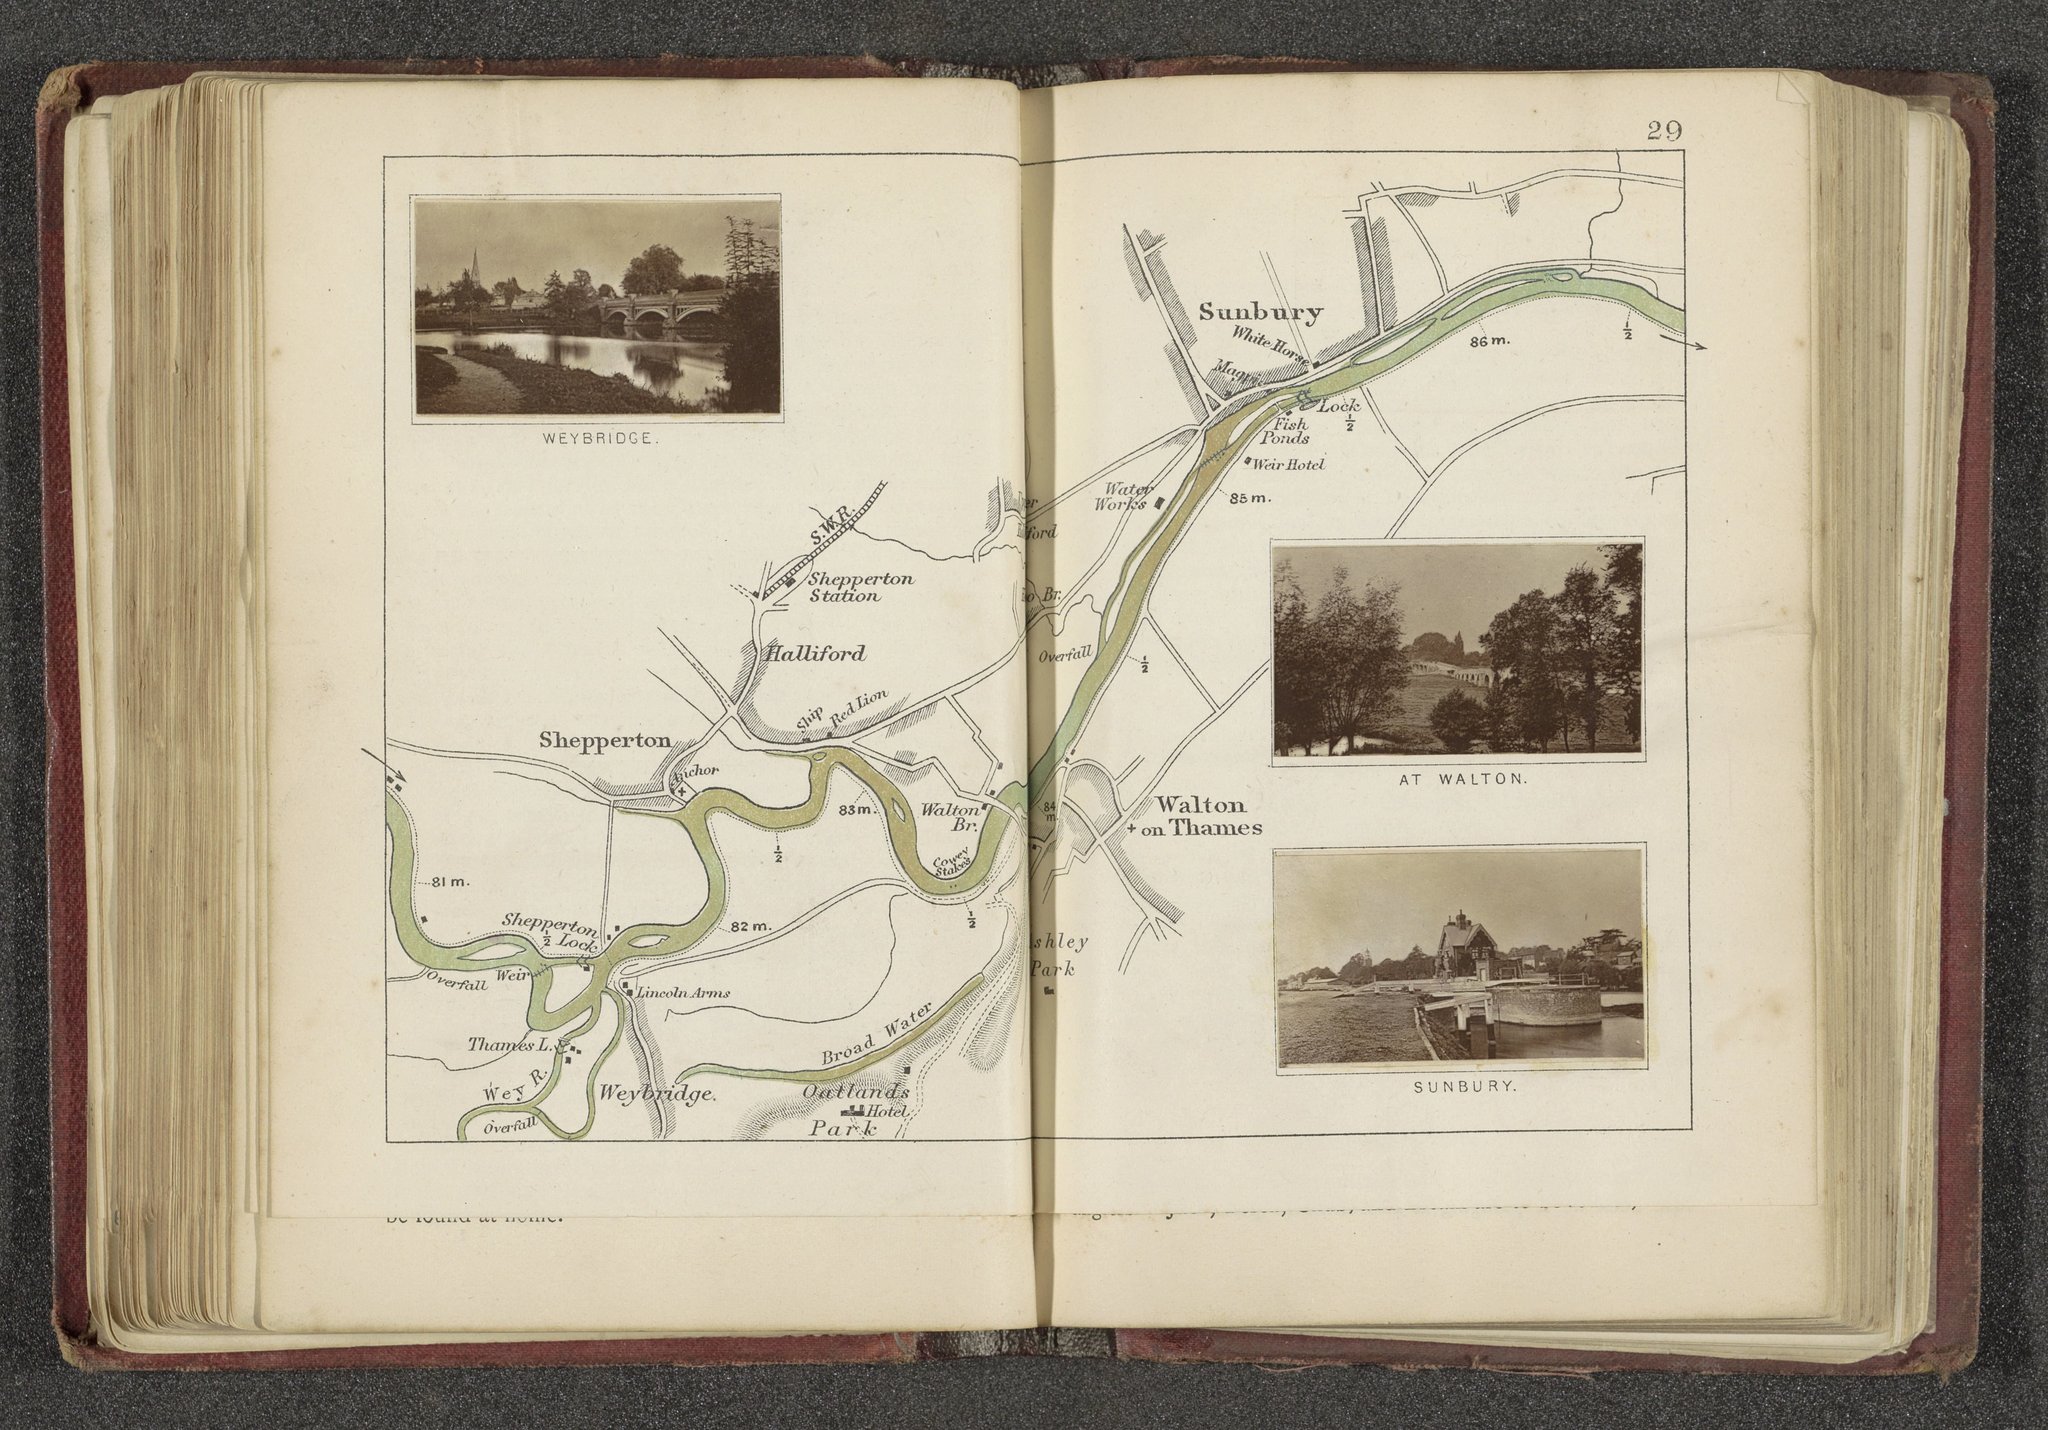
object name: page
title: Kaart met drie afbeeldingen van plaatsen langs de Theems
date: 1878-1879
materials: paper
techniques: engraving, woodburytype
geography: surrey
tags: river, bridge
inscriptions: inscription: ‘Weybridge. At Walton. Sunbury.’, number: ‘29’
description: Rechts: gezicht op Weybridge, links: gezicht op een brug bij Walton en een gezicht op Sunbury.